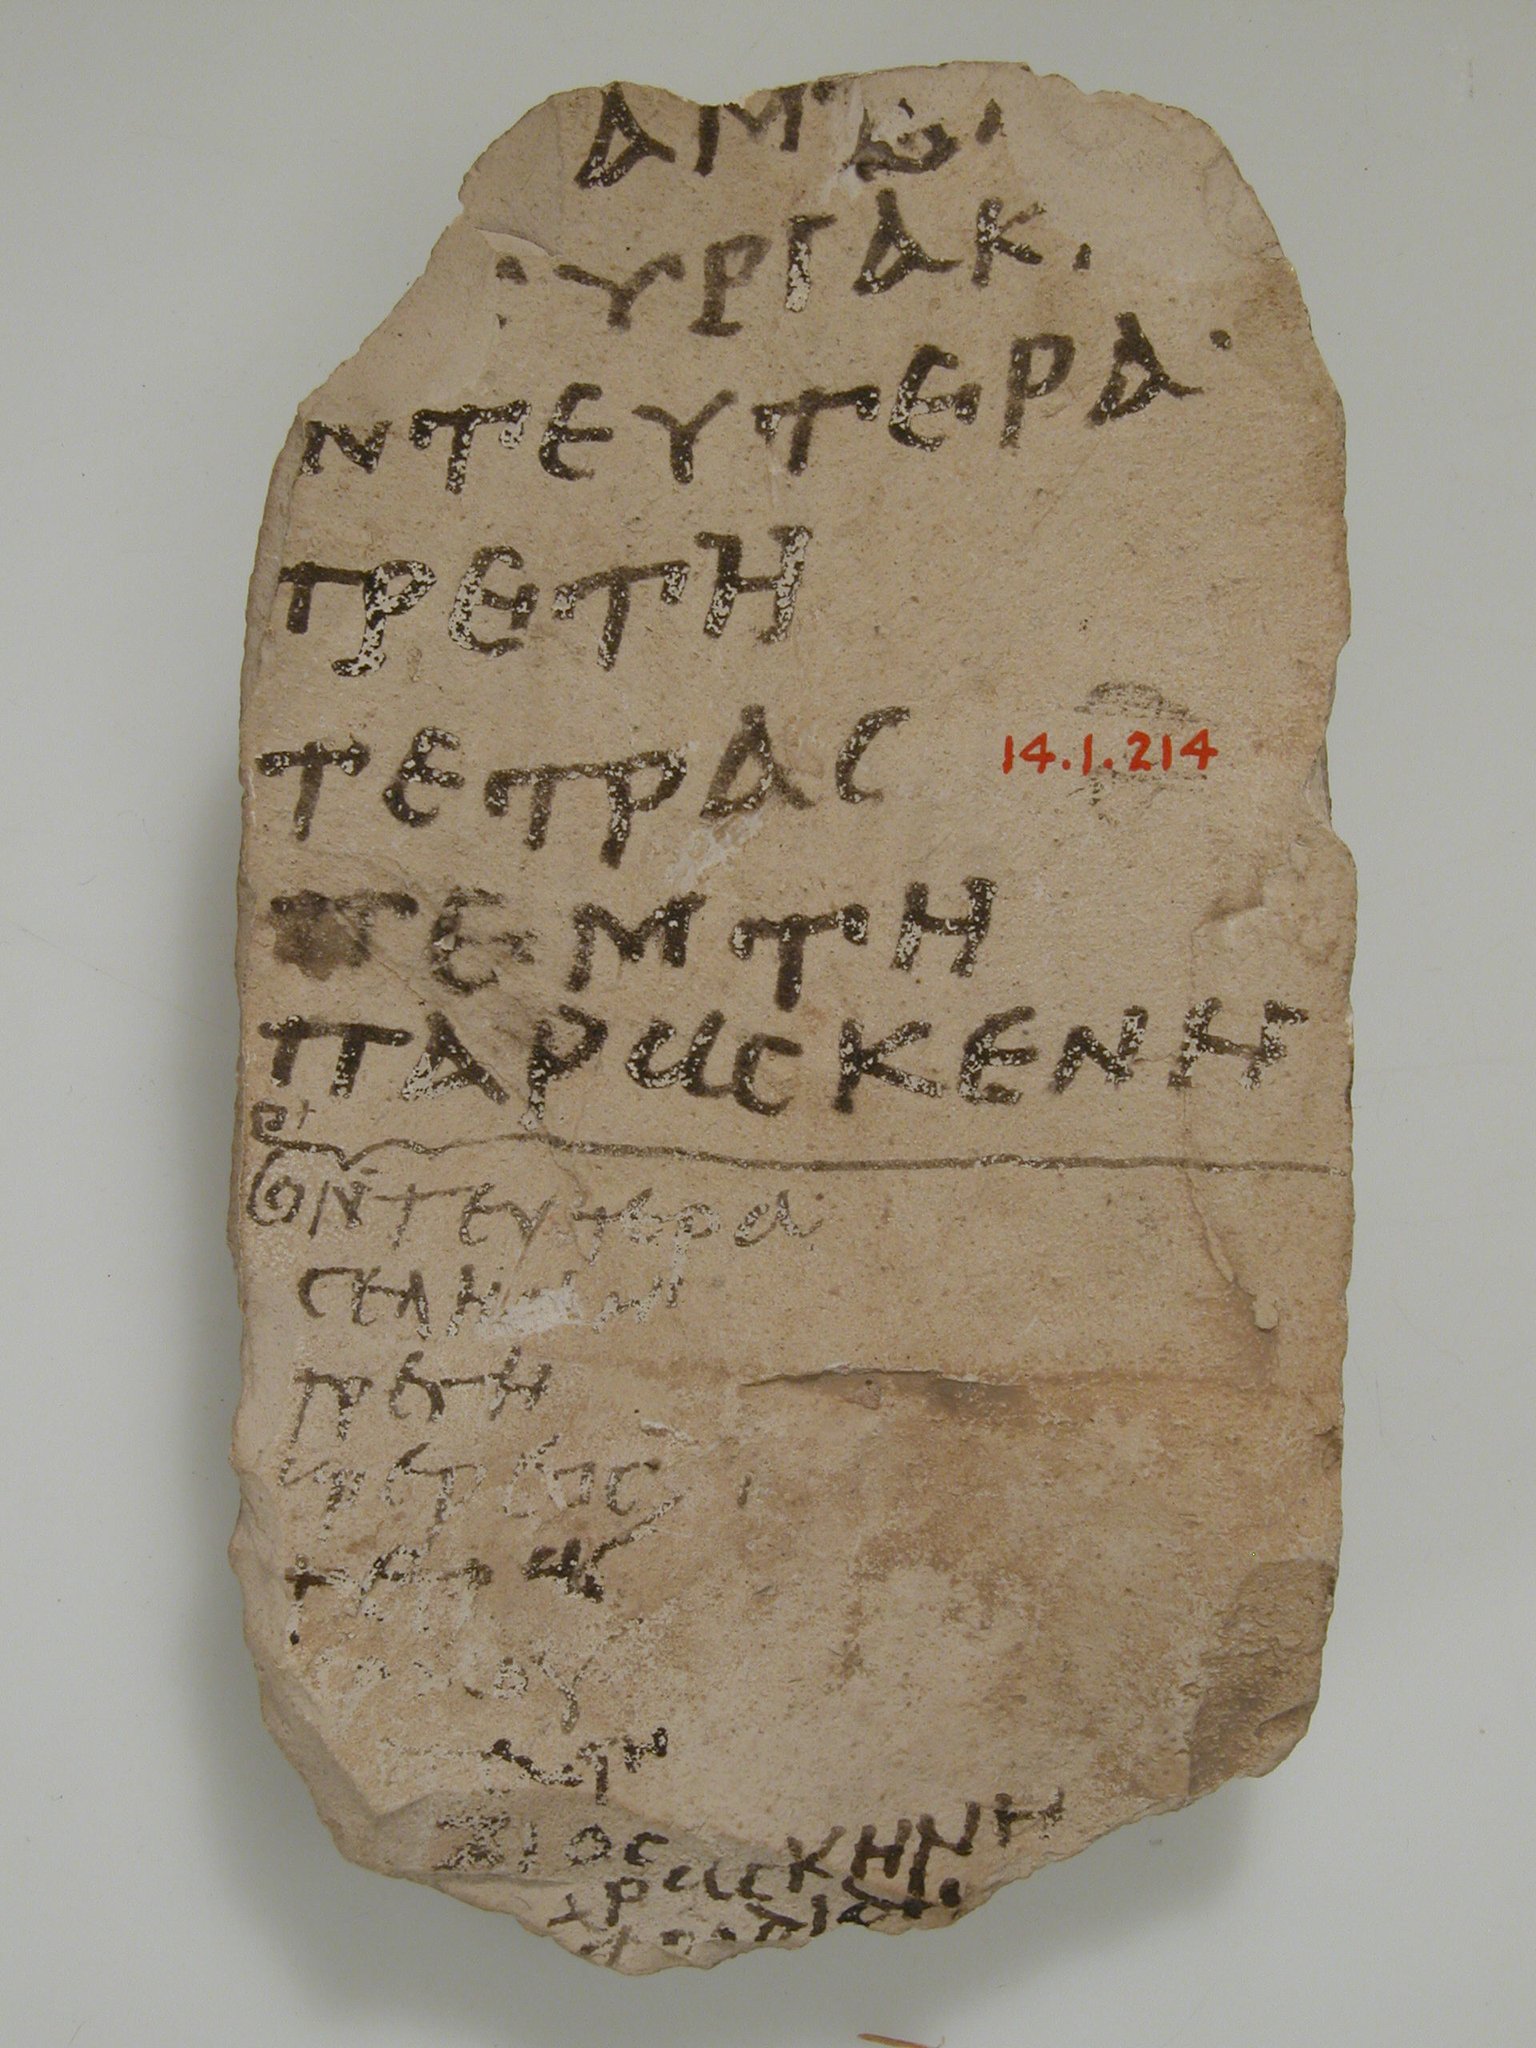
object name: ostrakon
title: Ostrakon with Lists of the Days of the Week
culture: coptic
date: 580-640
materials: ink, limestone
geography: egypt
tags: documents,greek